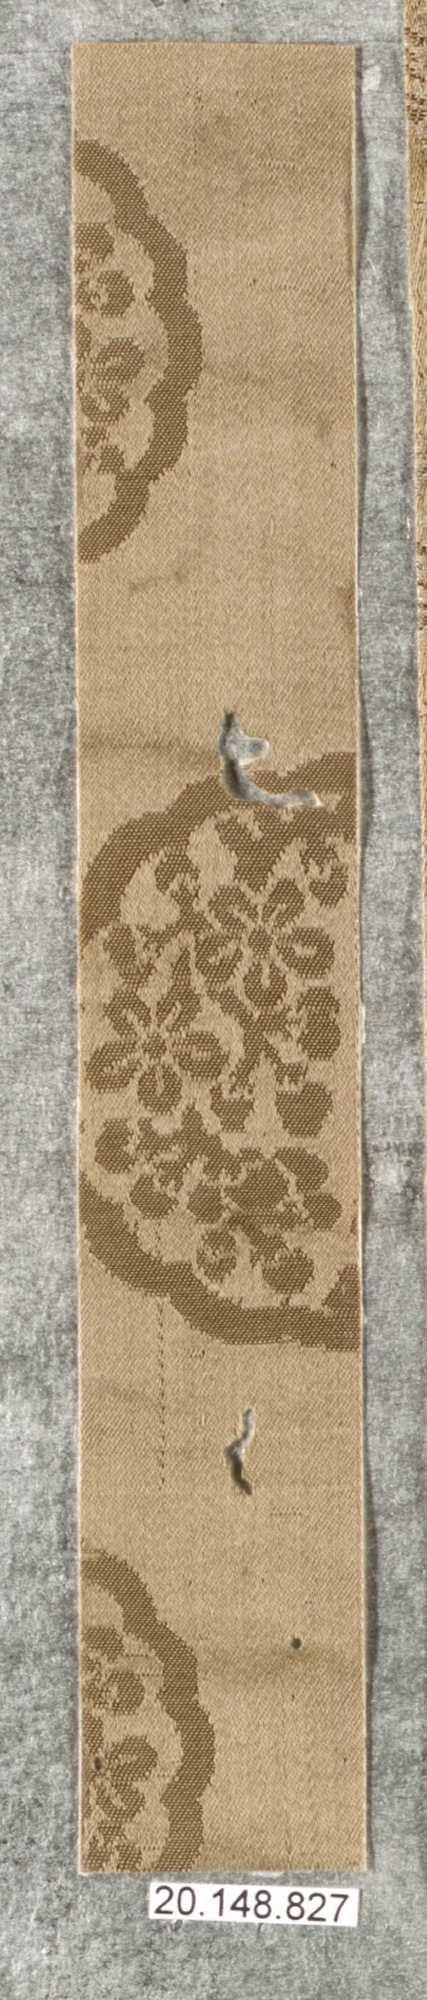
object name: piece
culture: japanese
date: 1701-1800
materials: silk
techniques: compound weave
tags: flowers